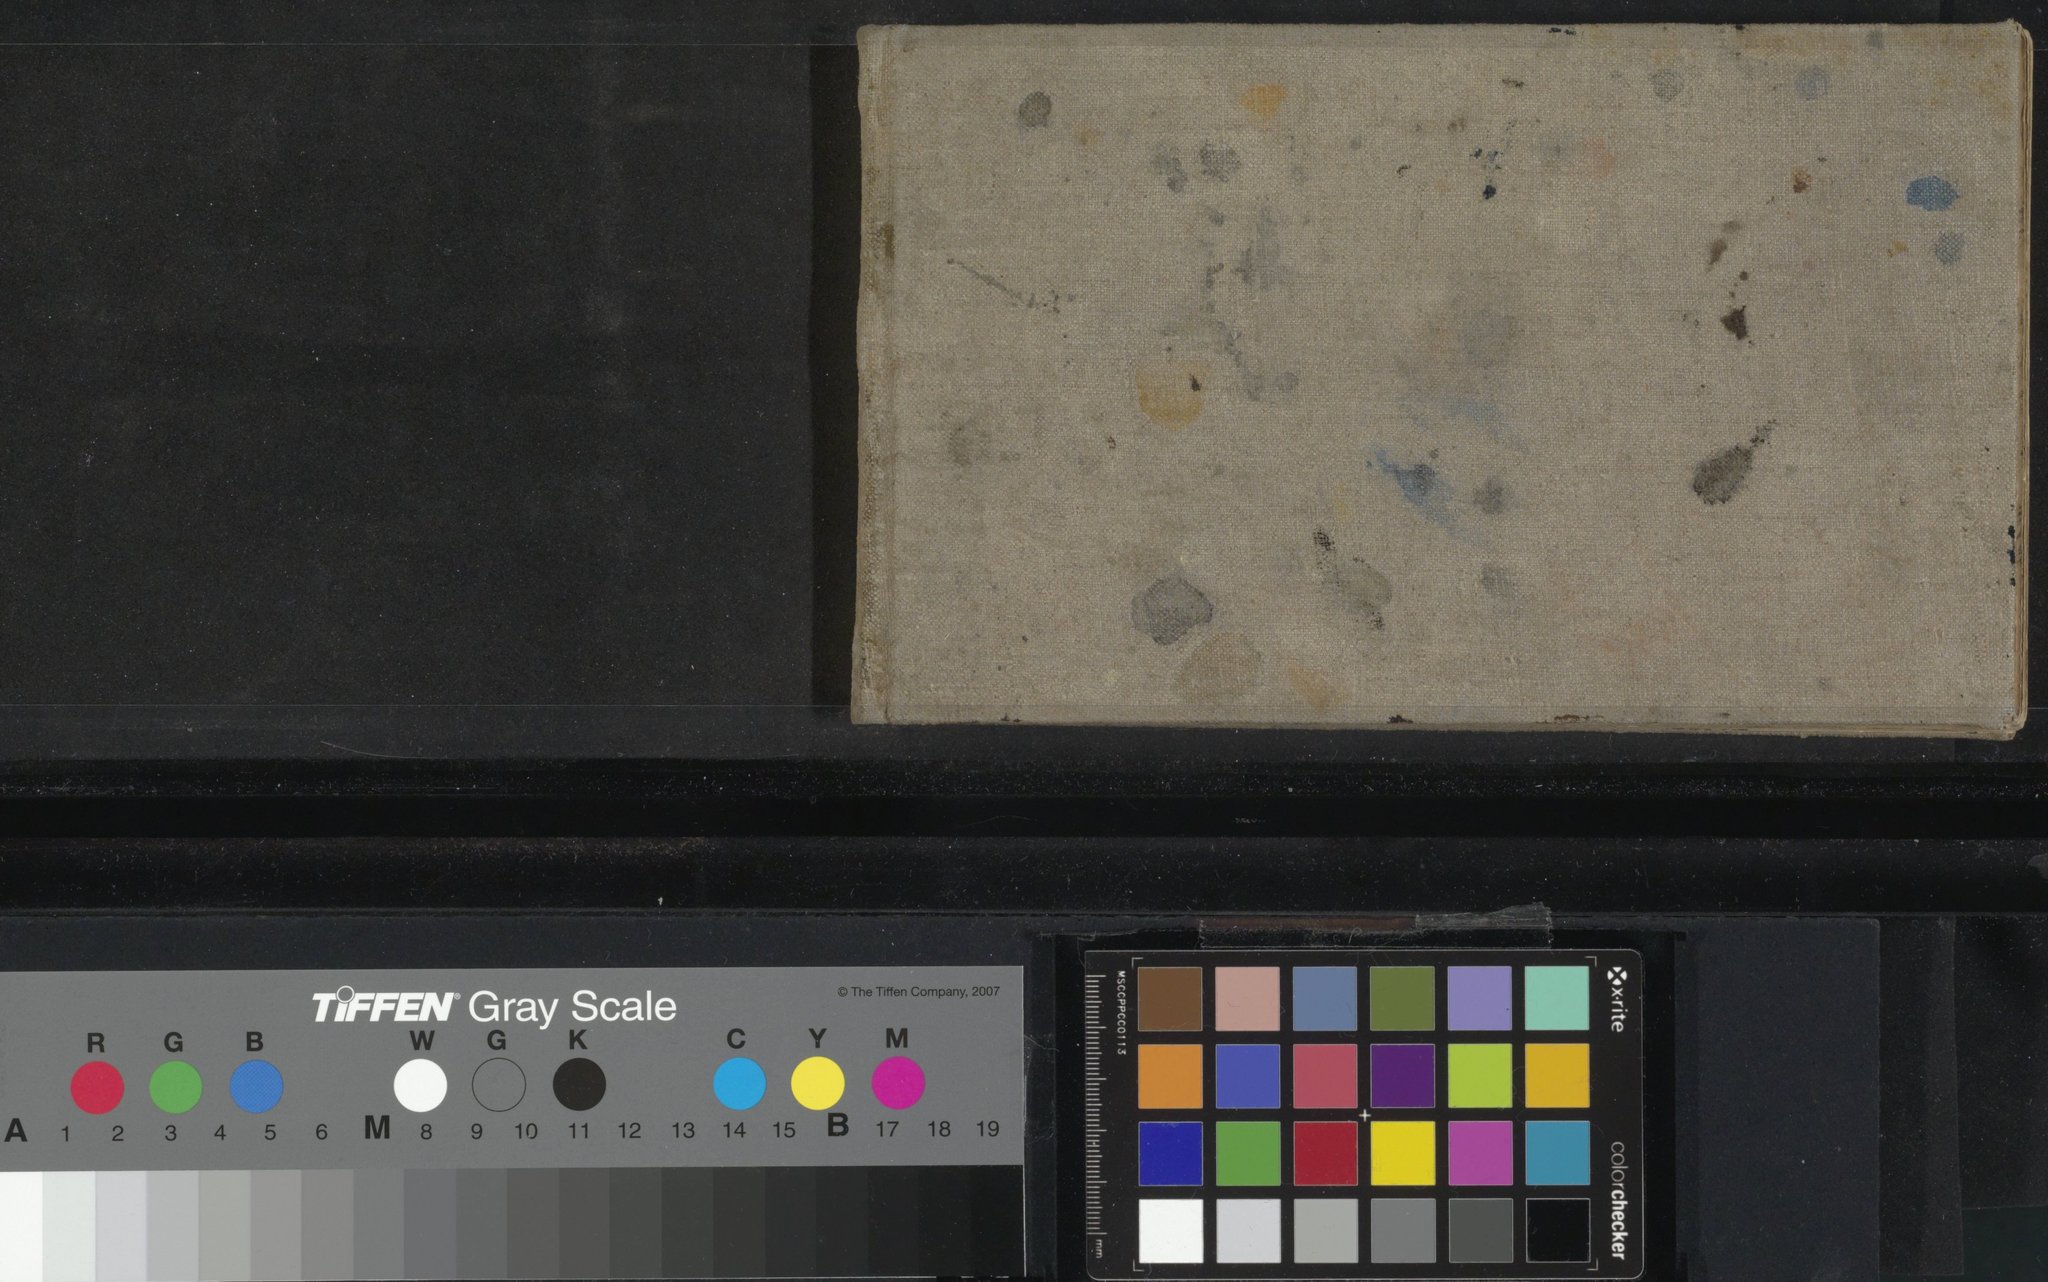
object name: sketchbook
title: Schetsboek met 25 bladen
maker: willem witsen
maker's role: draughtsman, painter, print maker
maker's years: 1860-1923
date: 1887-1897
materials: cardboard, chalk, linen, paper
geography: ede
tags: landscapes, public road, amsterdam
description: Schetsboek bestaande uit 25 bladen met landschappen en gezichten te Amsterdam en Ede.